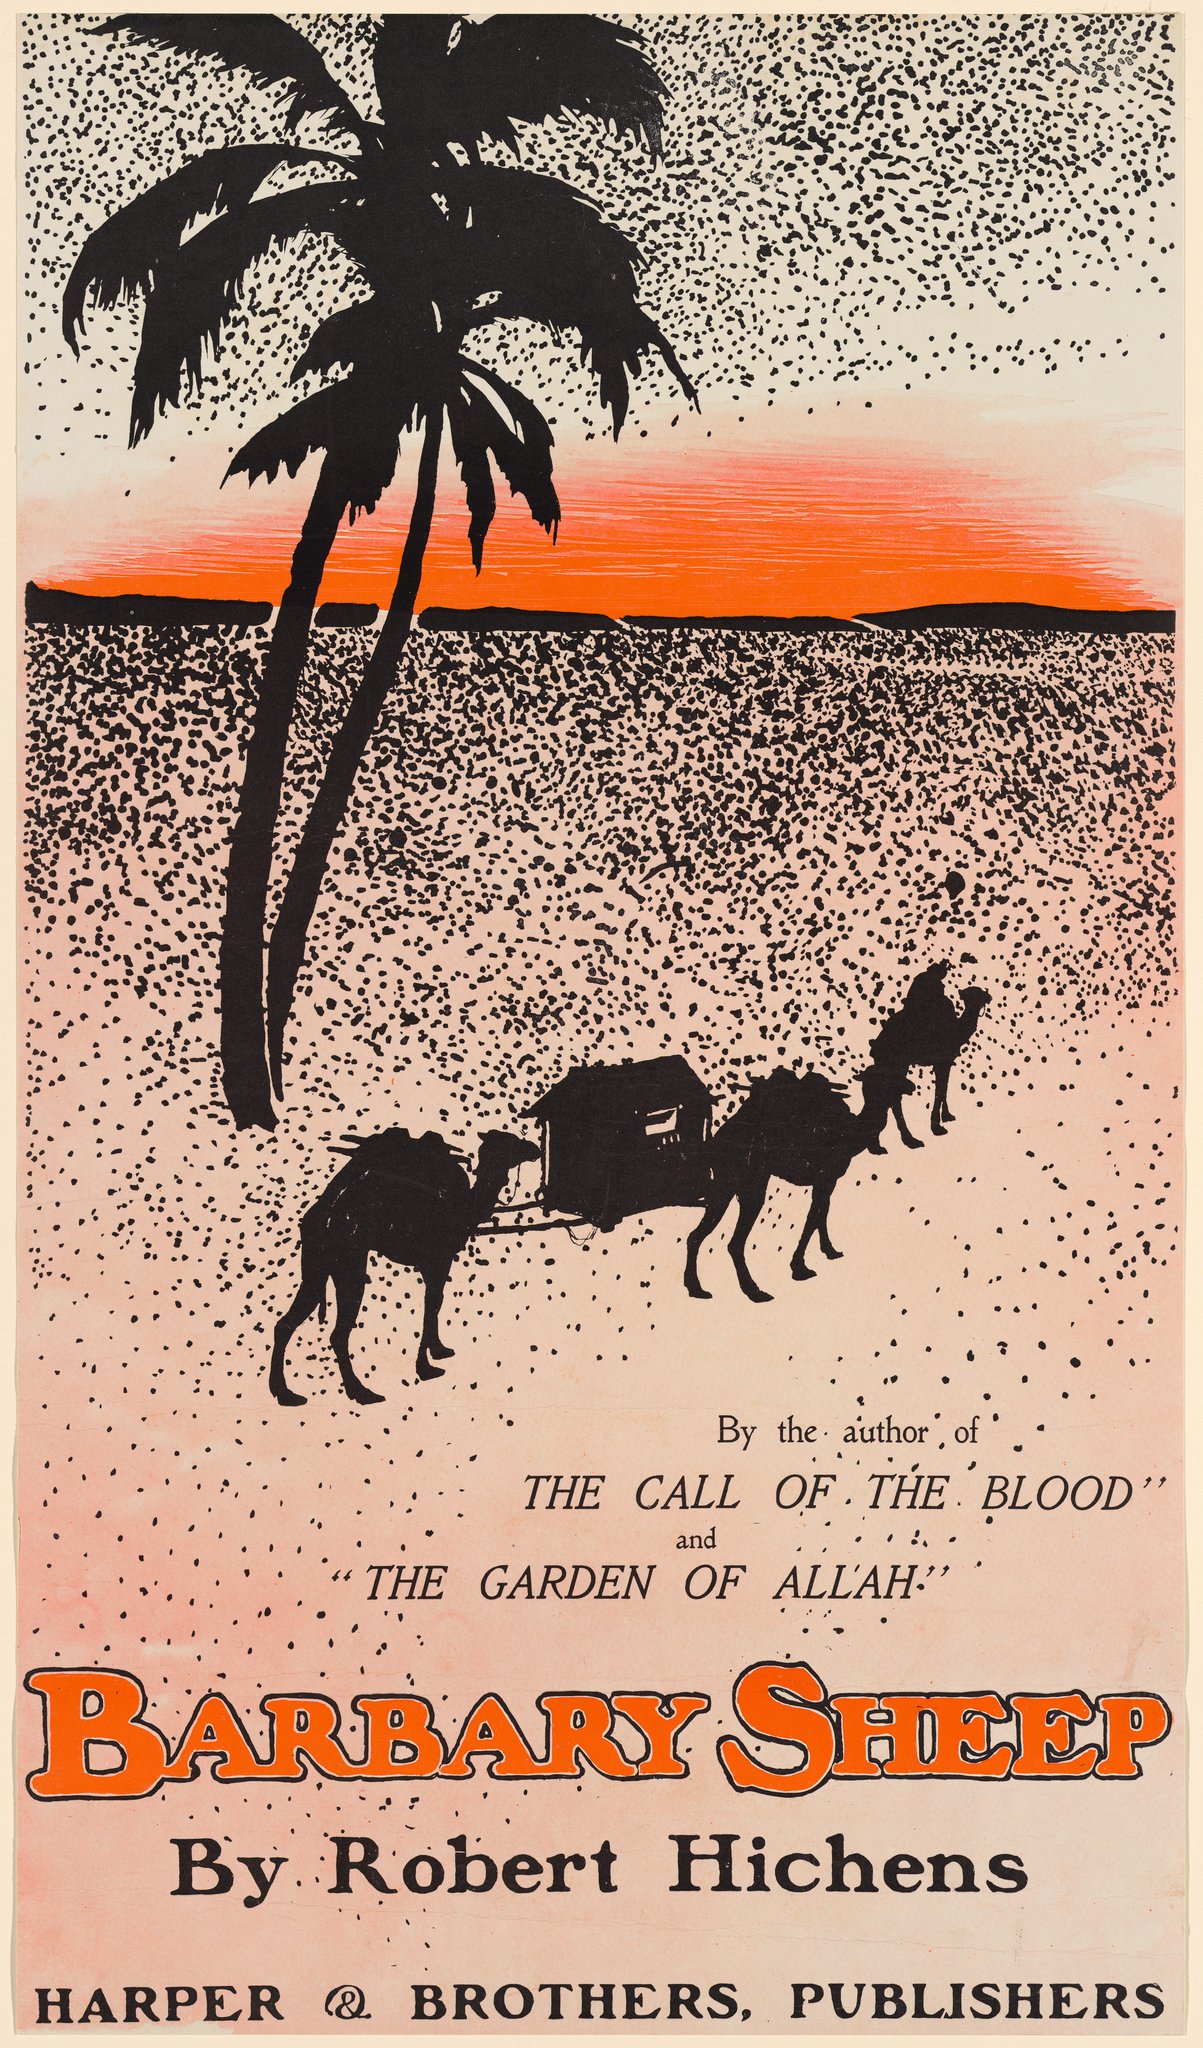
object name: poster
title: Barbary Sheep by Robert Hichens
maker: rachael robinson elmer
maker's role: artist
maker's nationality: american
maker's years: 1878-1919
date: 1907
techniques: lithograph